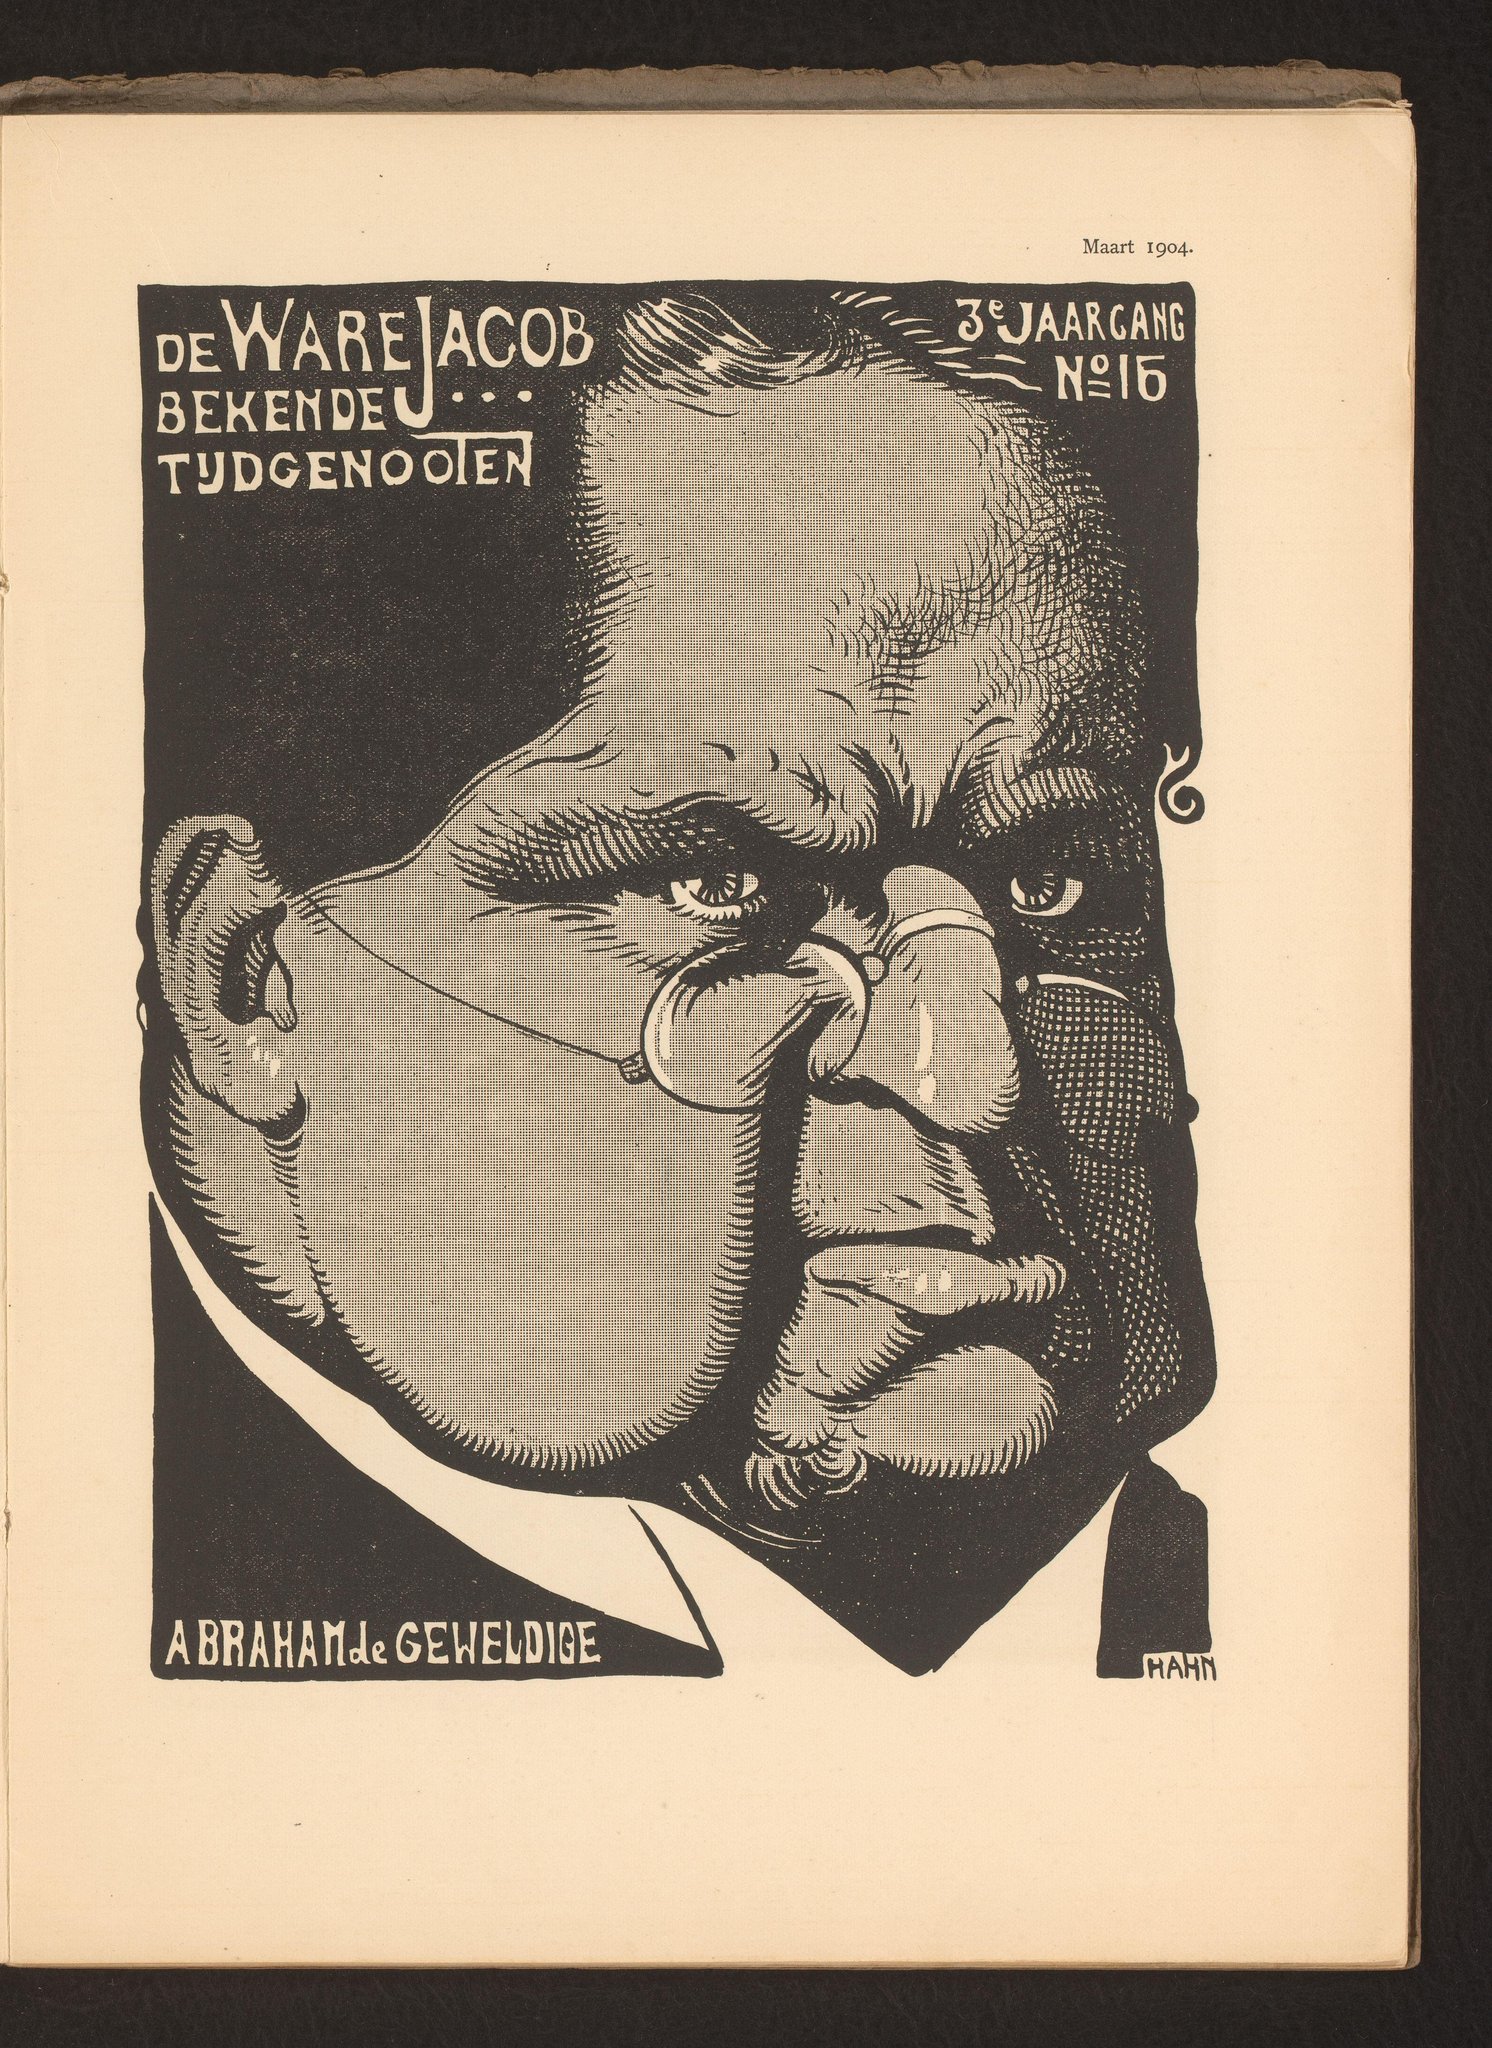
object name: cartoon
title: Abraham de Geweldige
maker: albert hahn (i)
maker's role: draughtsman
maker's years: 1877-1918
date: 1903-1904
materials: paper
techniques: autotype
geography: netherlands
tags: the hague, abraham kuyper, caricatures (human types), political caricatures and satires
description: Karikatuur van Abraham Kuyper, maart 1904. Onderdeel van het boek 'Albert Hahn Prenten', heruitgave van een selectie politieke prenten uit de periode 1902-1906.